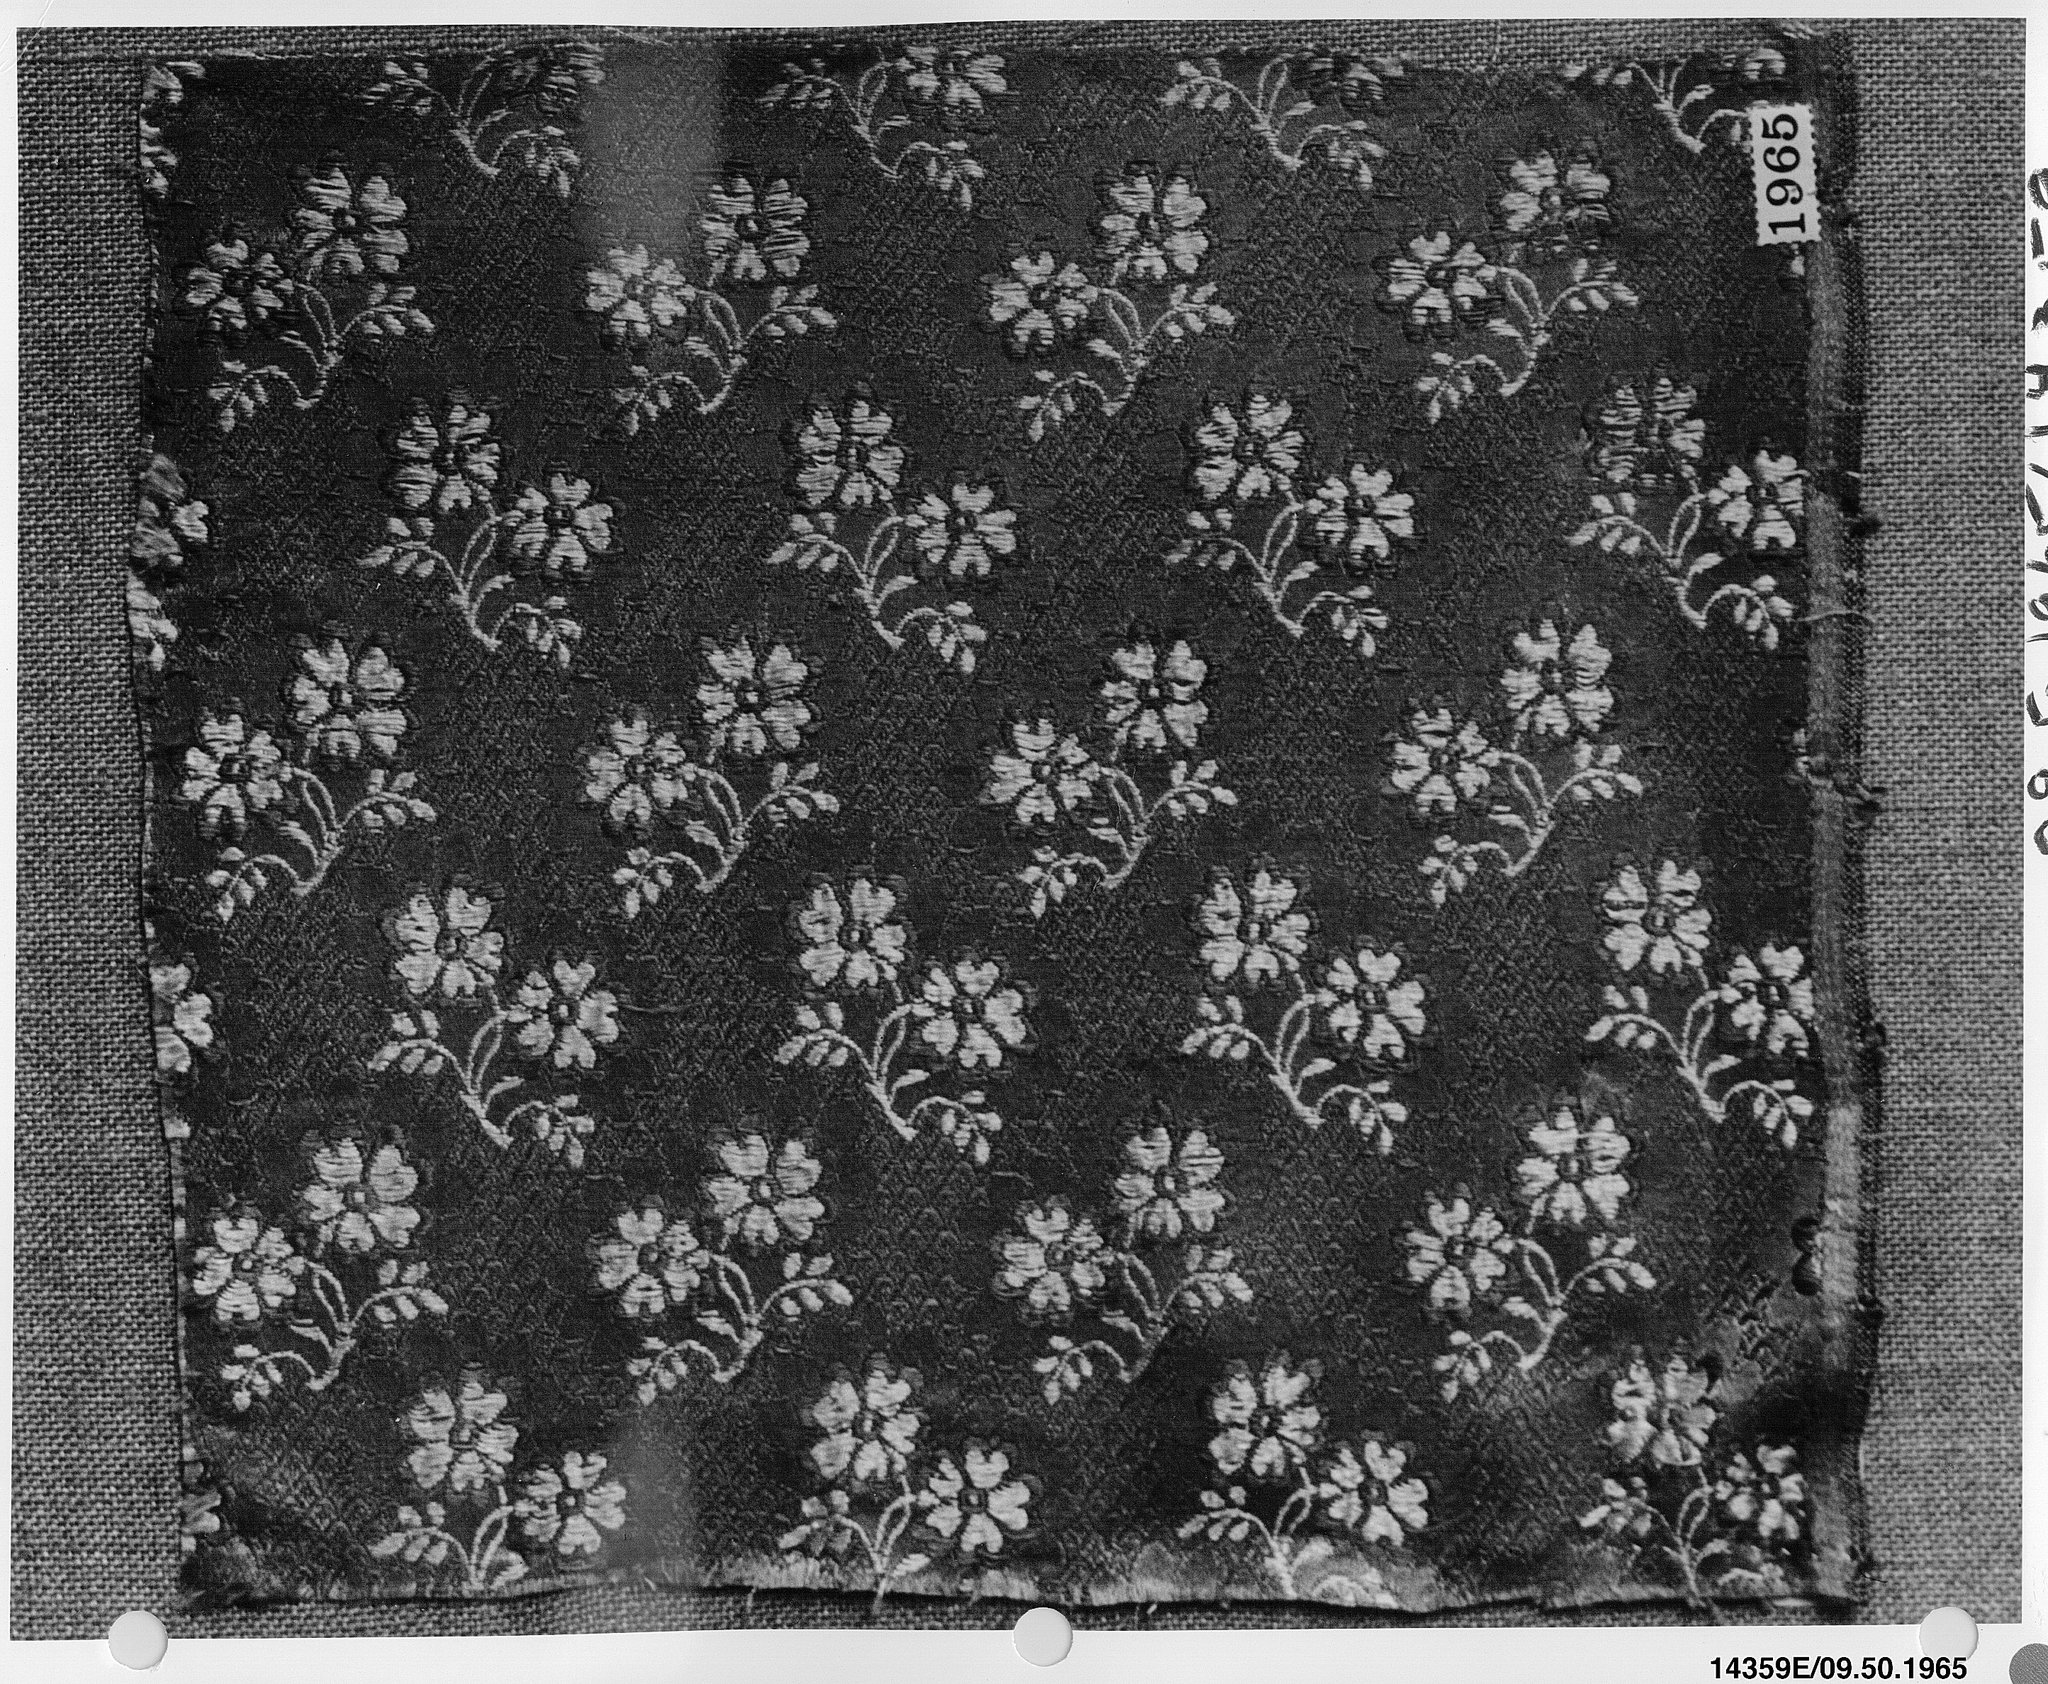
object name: piece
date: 1701-1800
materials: silk